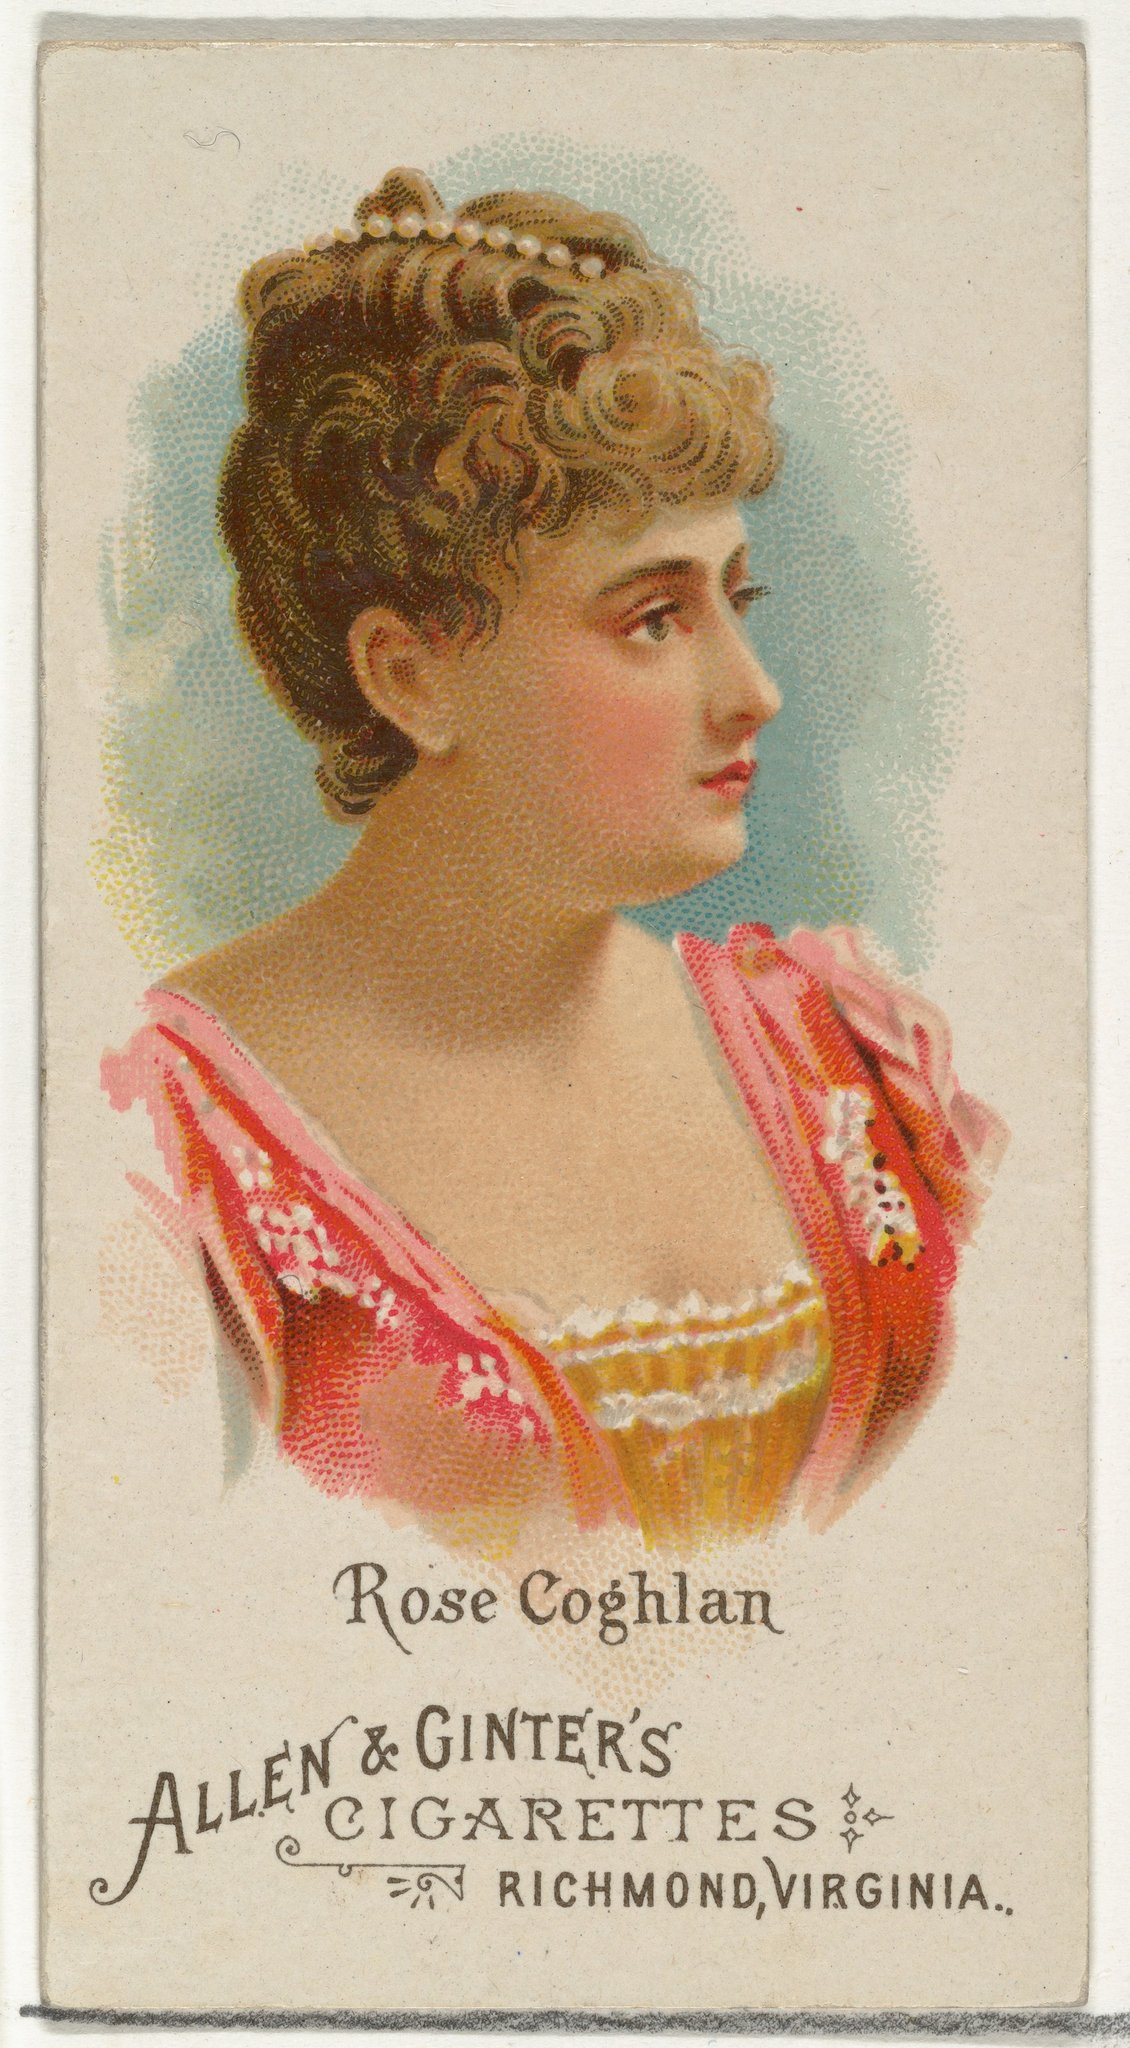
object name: print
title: Rose Coghlan, from World's Beauties, Series 1 (N26) for Allen & Ginter Cigarettes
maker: allen & ginter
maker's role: publisher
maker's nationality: american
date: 1888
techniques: color lithograph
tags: women